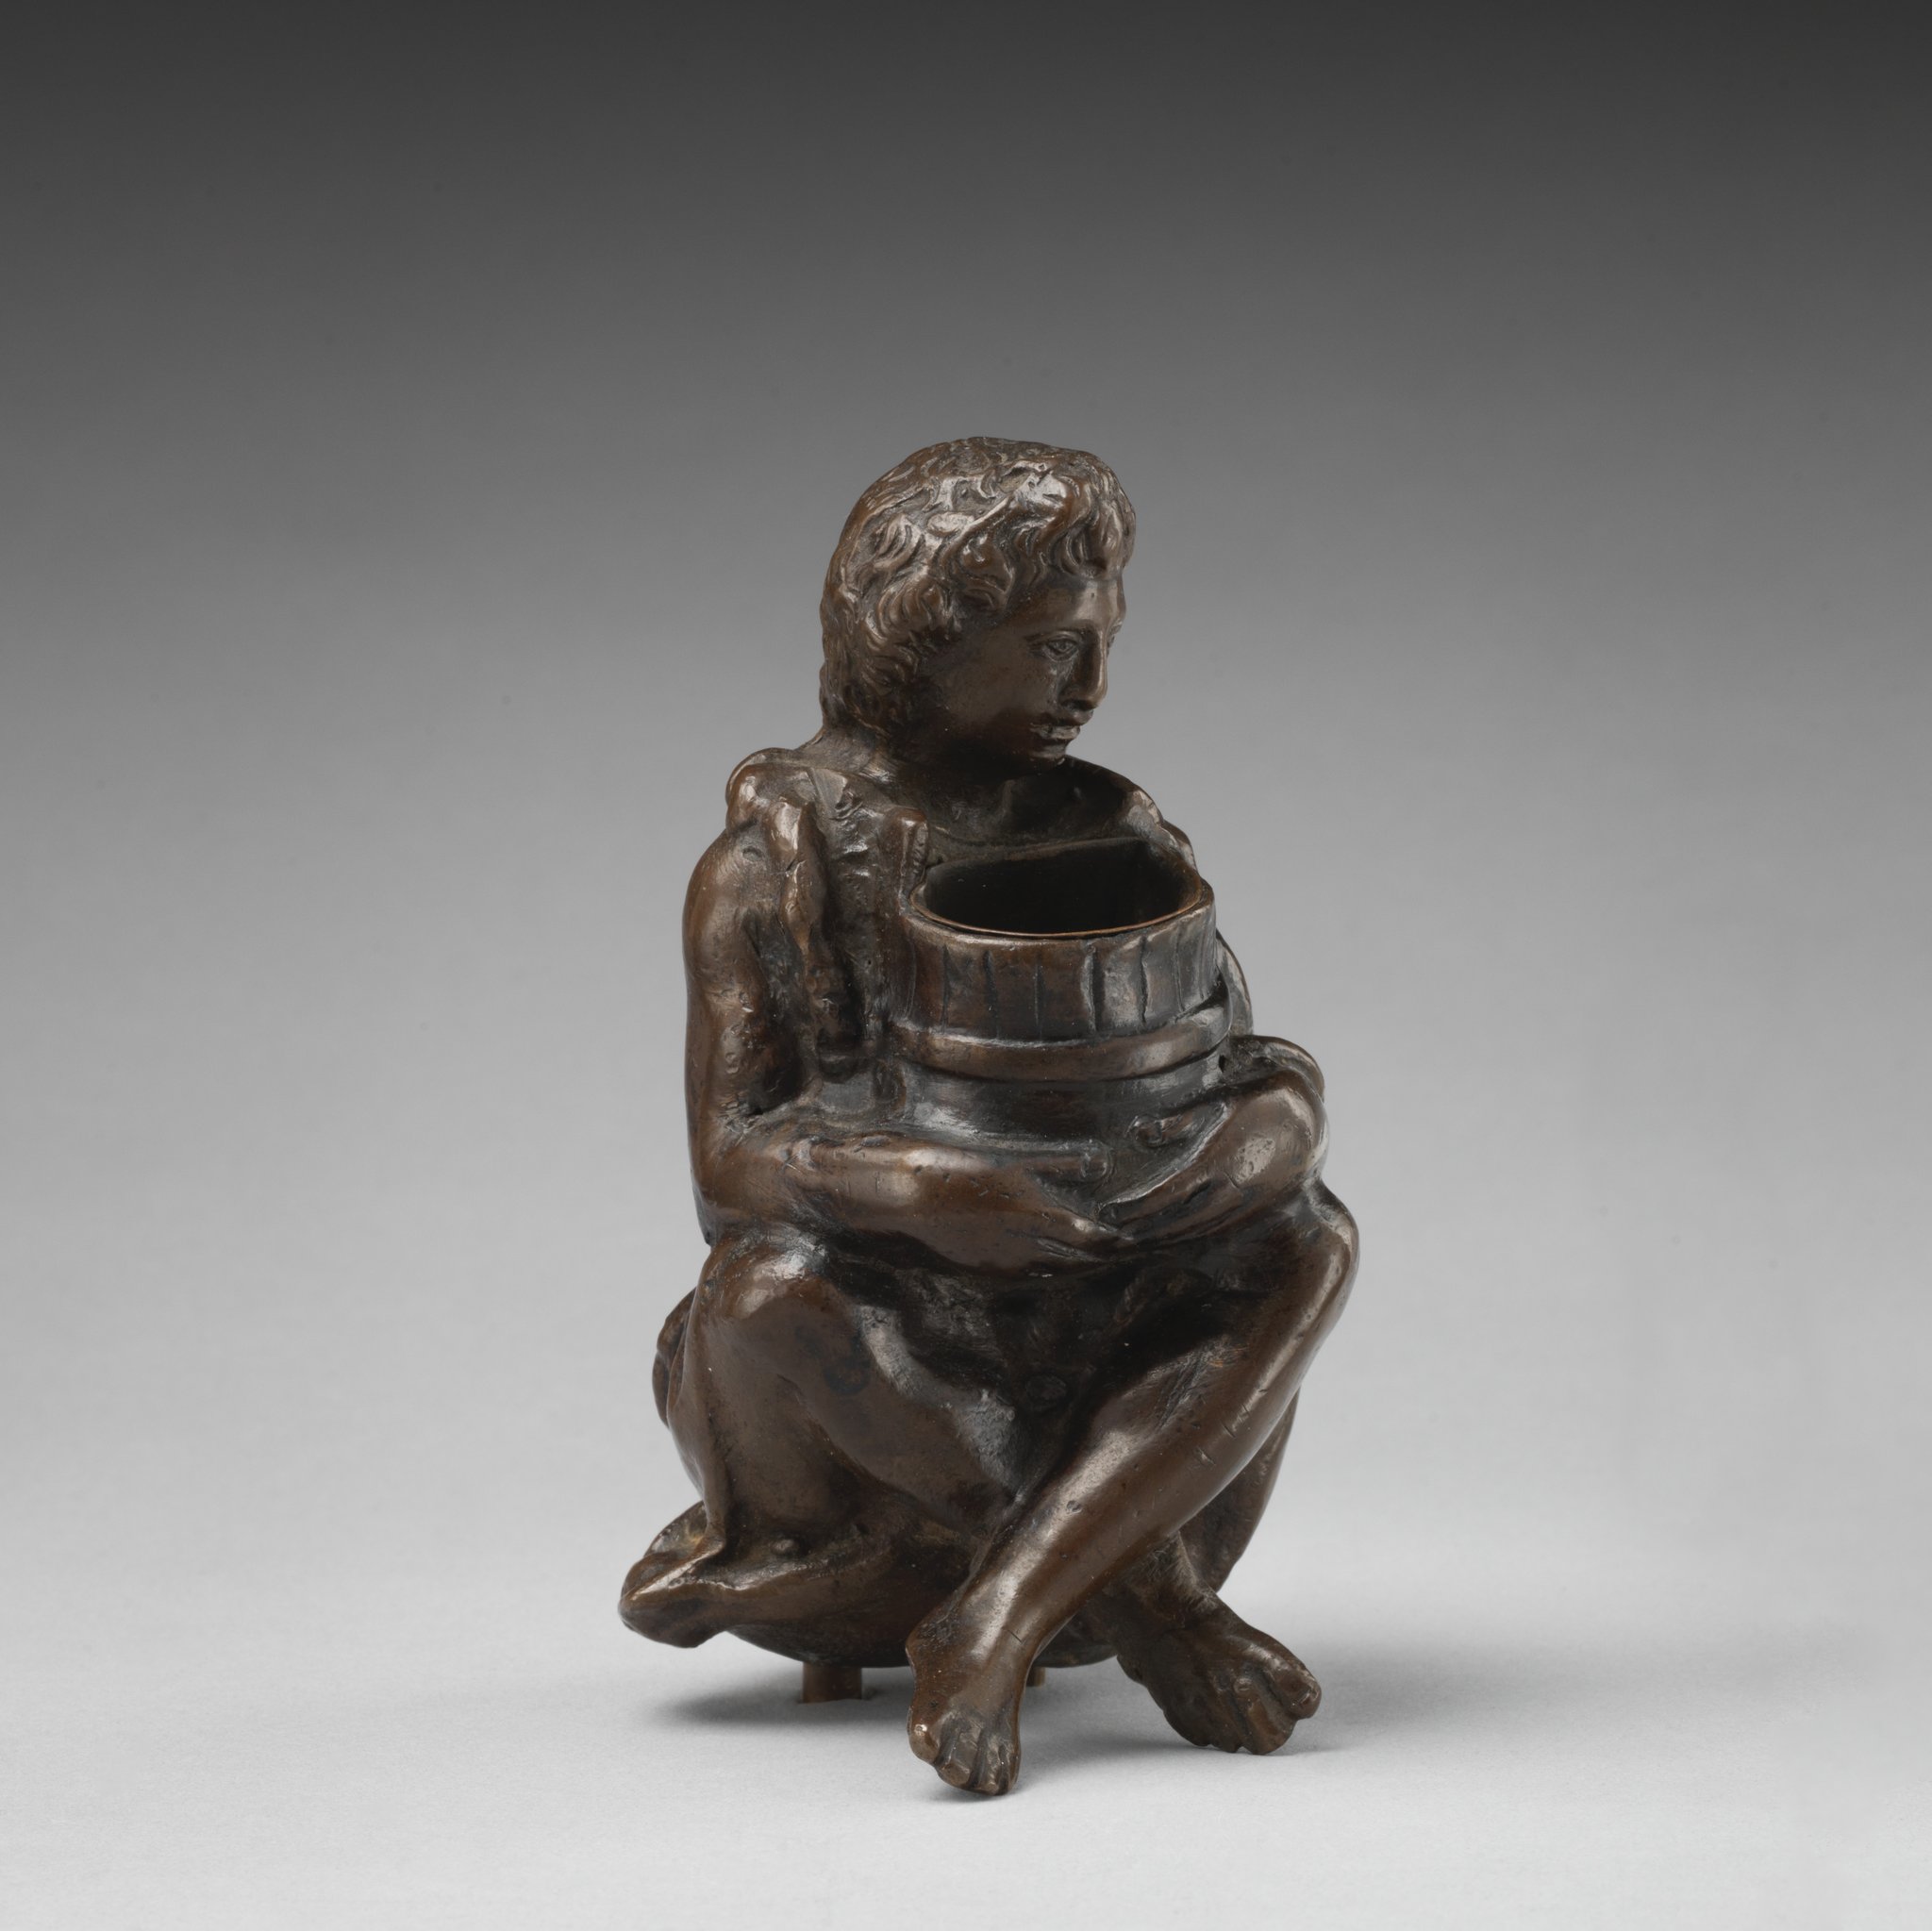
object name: inkstand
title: Boy with a barrel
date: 1501-1600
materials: bronze, marble, patina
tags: boys